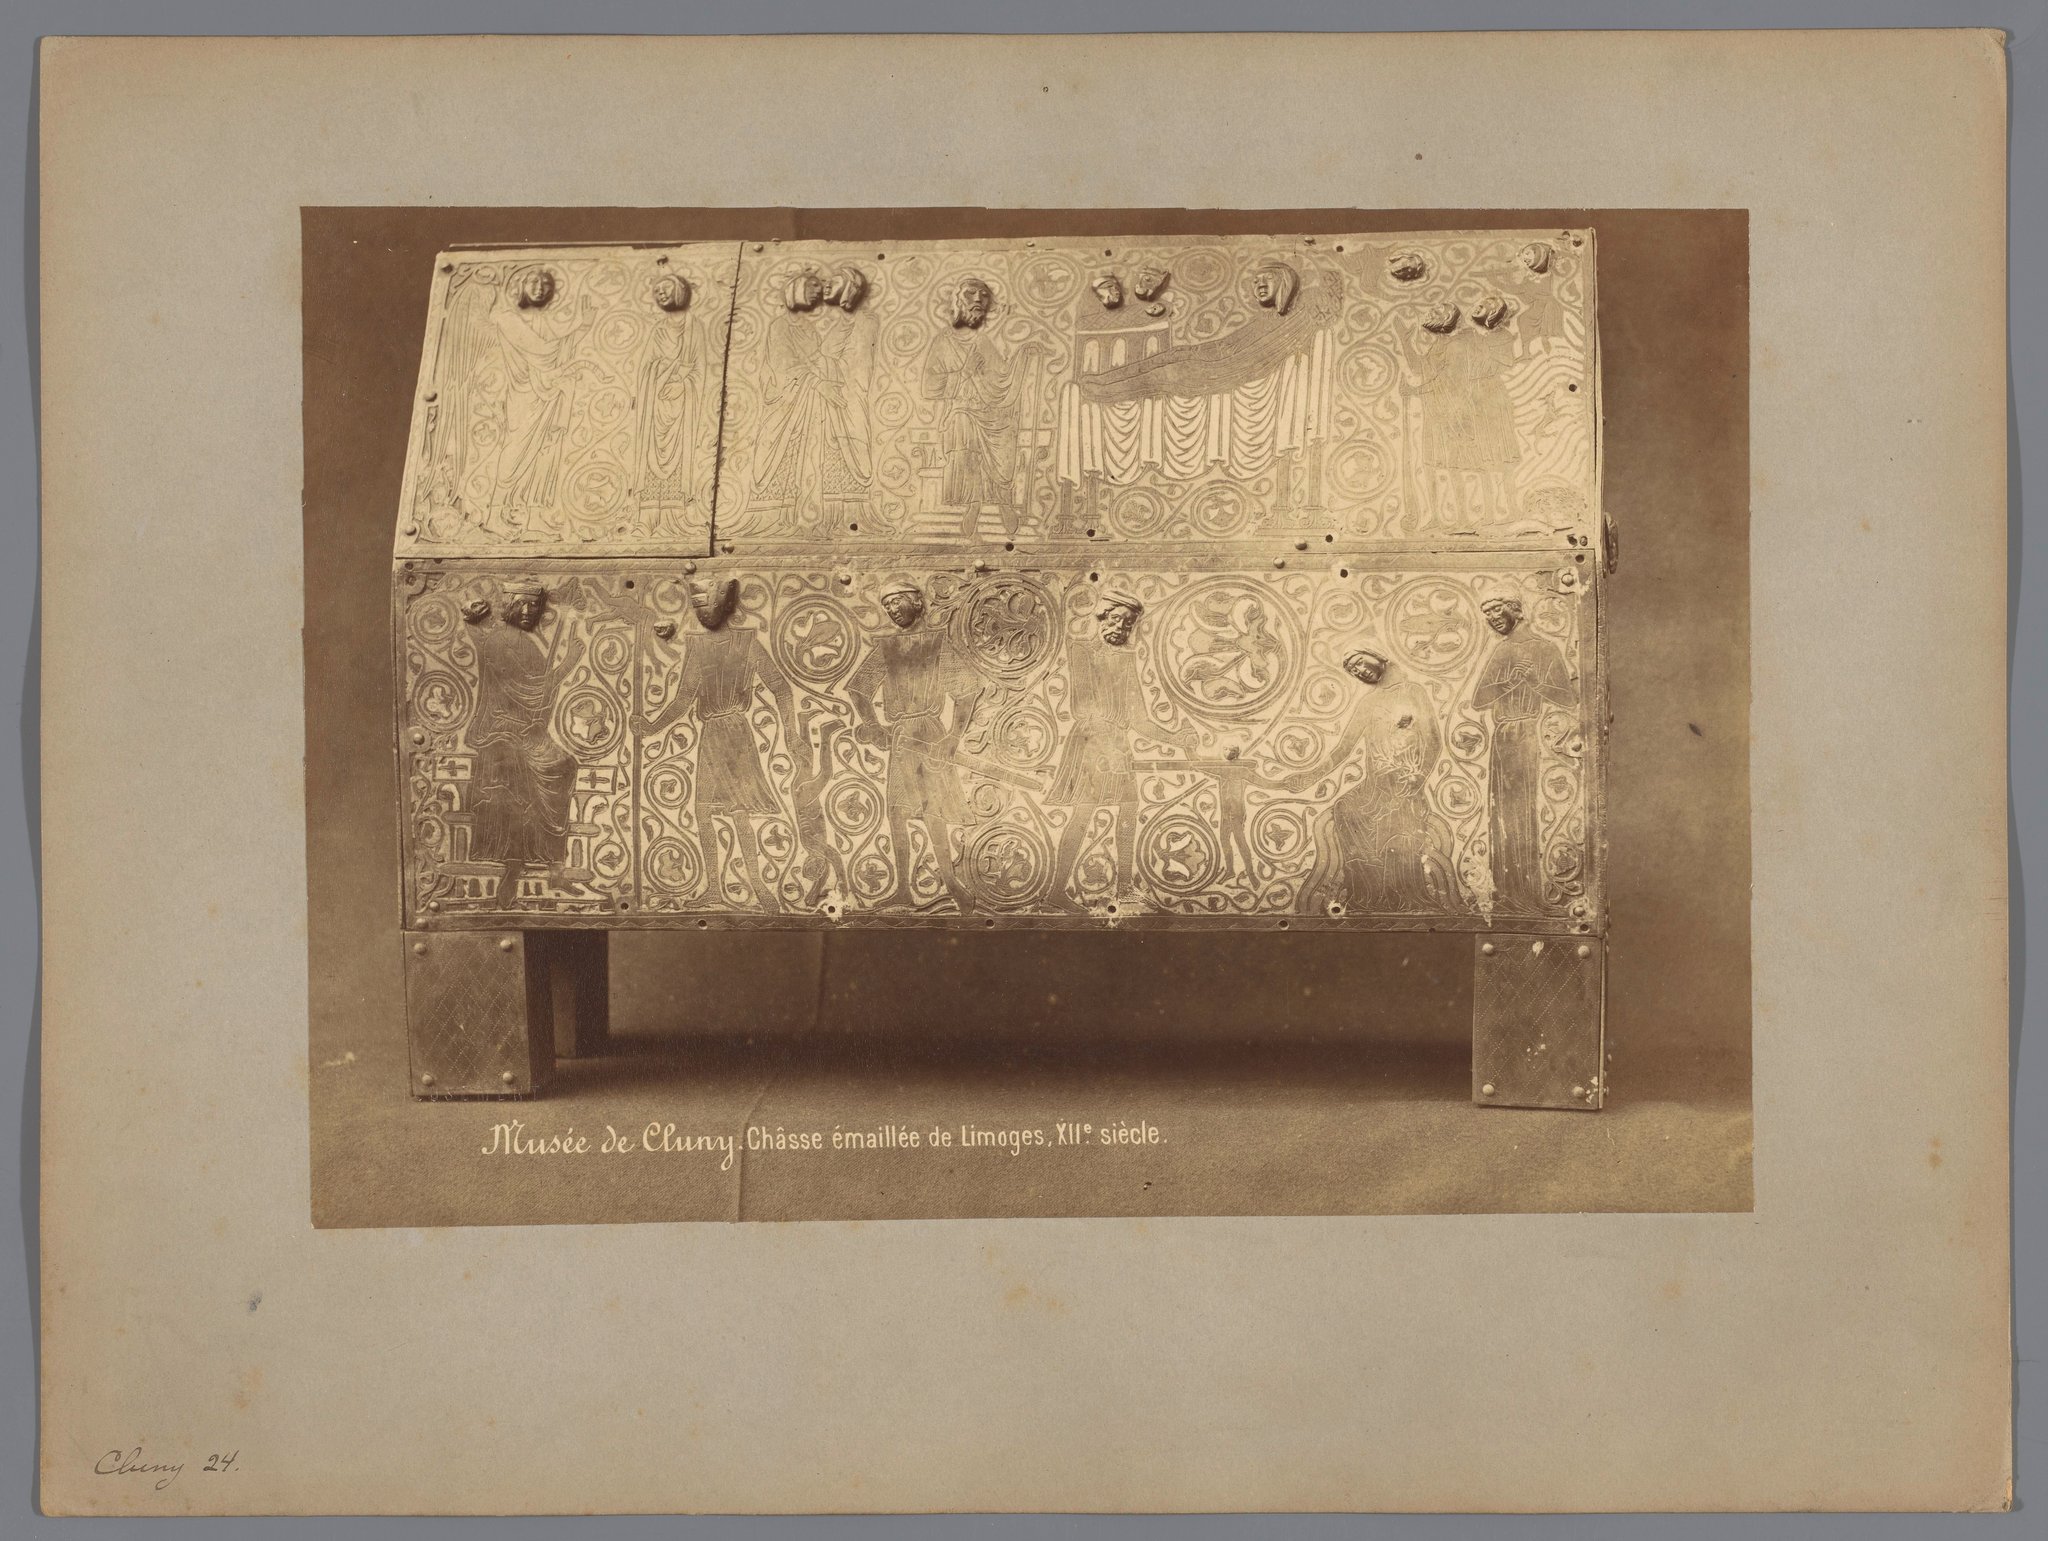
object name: photograph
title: Musée de Cluny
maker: séraphin-médéric mieusement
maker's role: fotograaf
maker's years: 1840-1905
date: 1850-1900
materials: cardboard, photographic support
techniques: albumen print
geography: paris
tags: chest, coffer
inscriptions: number: ‘Cluny 24’, workshop stamp: ‘Mieusement/ Photographe’, collector's mark: ‘Rijks-normaalschool voor teekenonderwijzers Amsterdam’ Lugt 3937